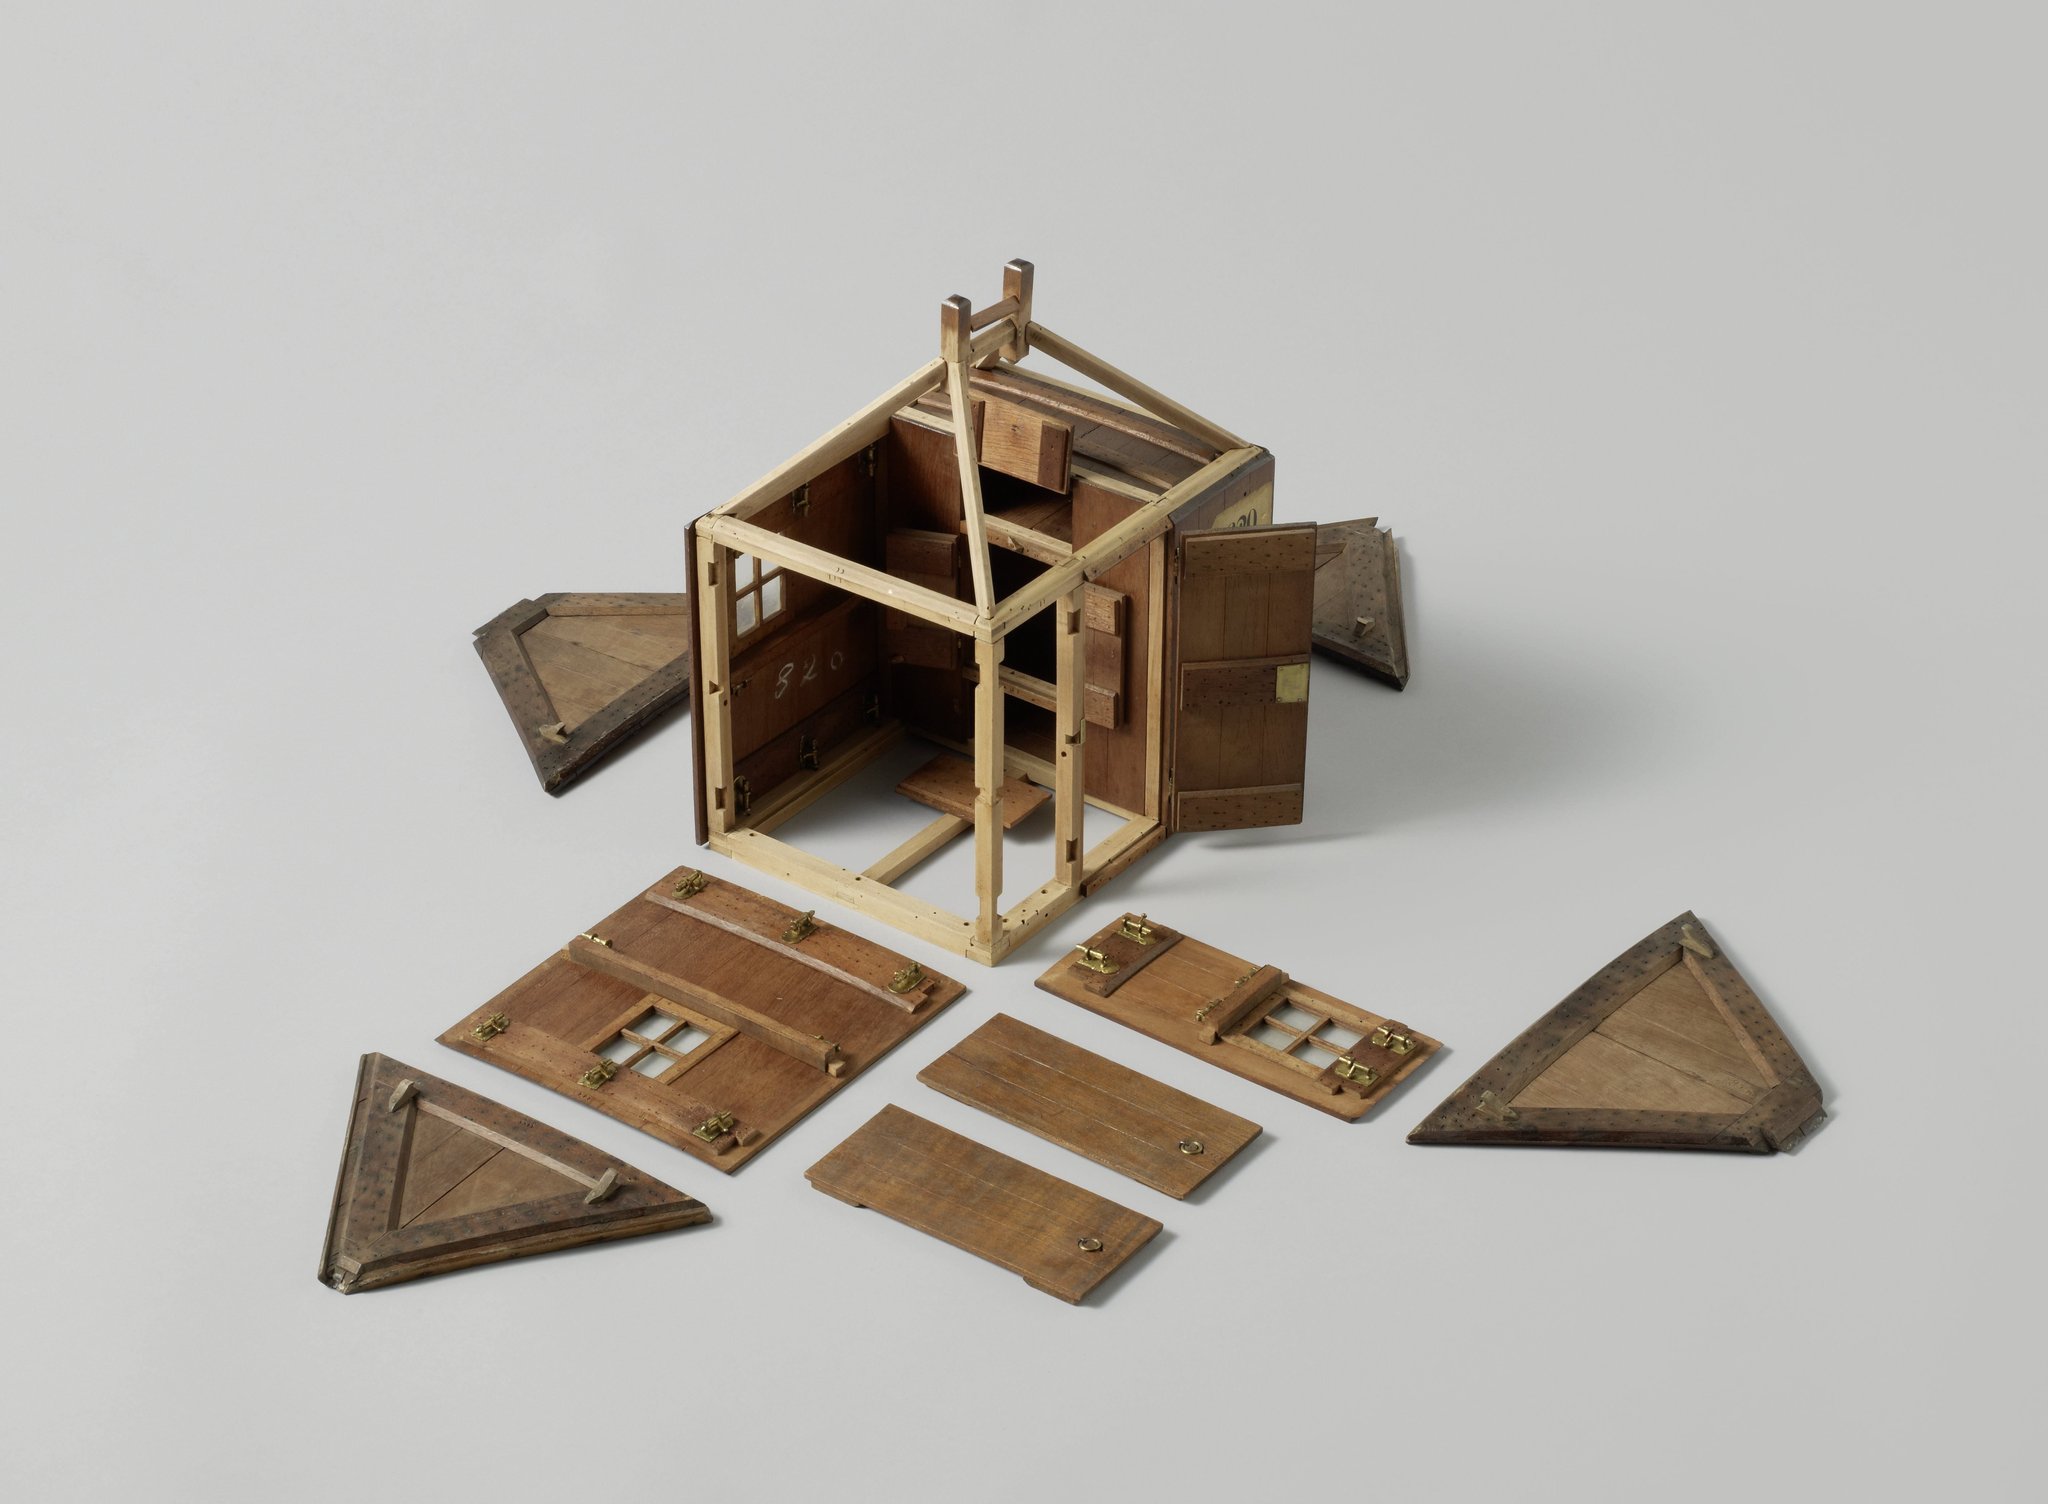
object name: demonstration model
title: Model of a Cabin for Telegraph Personnel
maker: Anonymous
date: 1803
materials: brass, glass, wood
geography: netherlands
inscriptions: label, right of the door: ‘820’ former inventory label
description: Signalman cabin. Model, 1803. The signalman's cabin was located near the telegraph. It was built with standard elements, making it easy to reassemble.